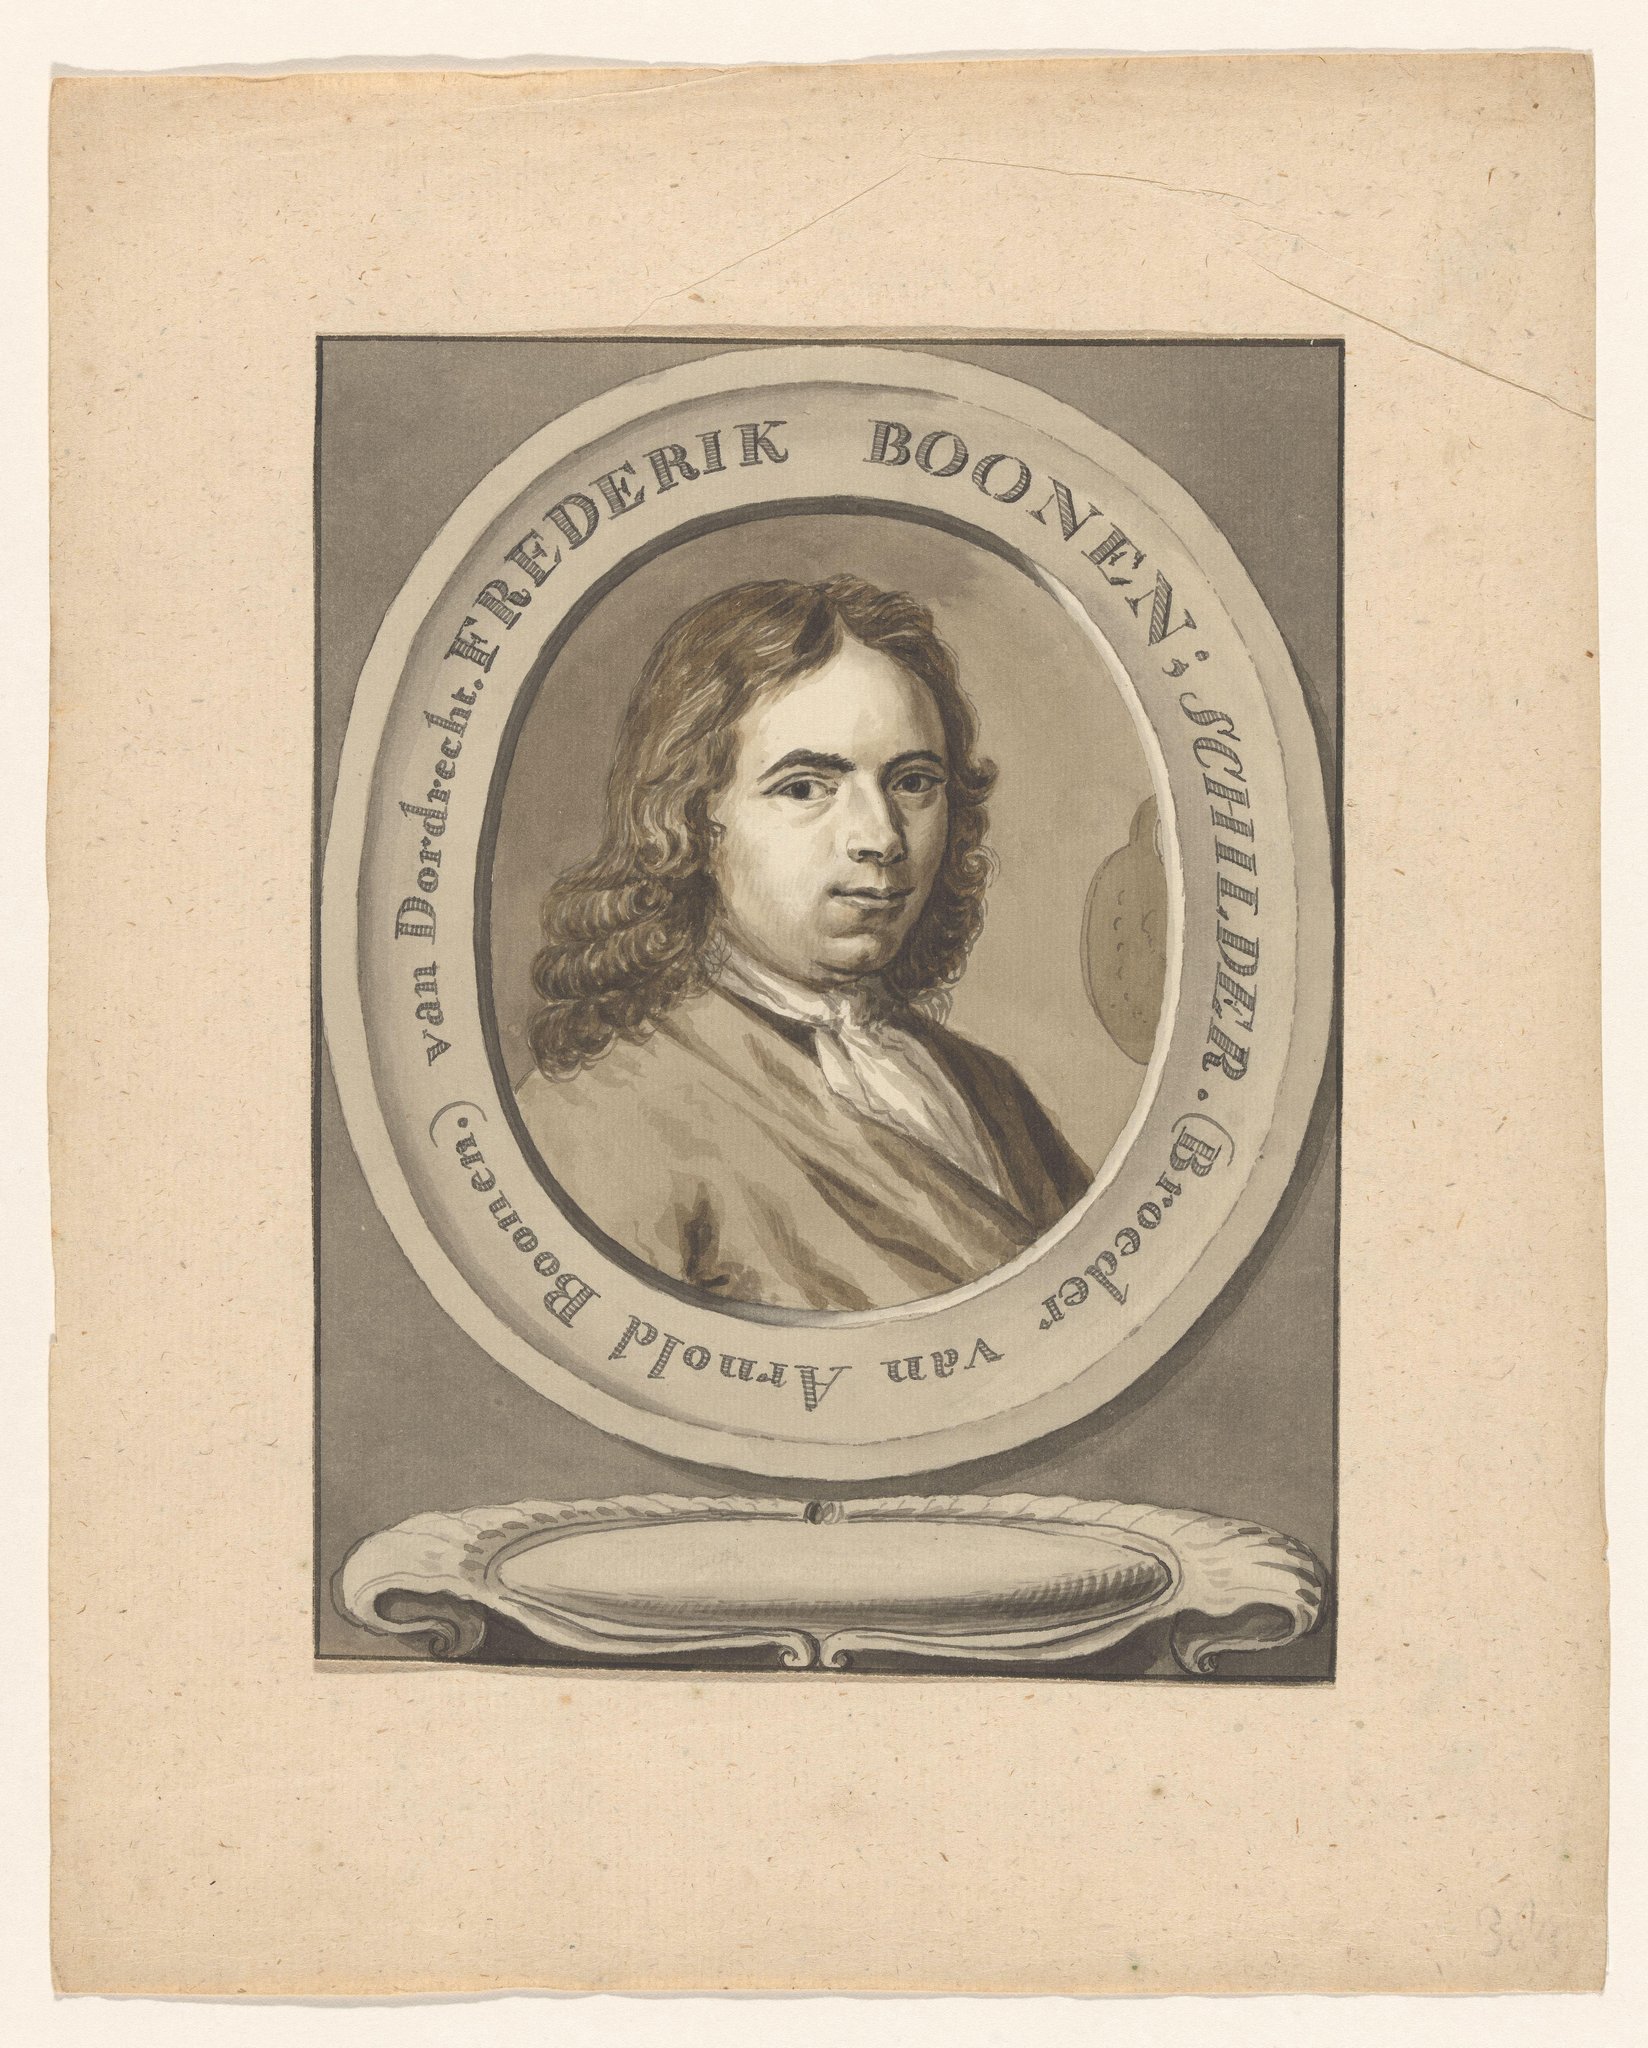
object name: drawing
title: Portret van de kunstschilder Frederik Boonen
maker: Anonymous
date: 1738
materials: pencil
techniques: brush, pen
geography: netherlands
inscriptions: date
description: Betiteld op het ovaal rond het portret, in contemporain handschrift.